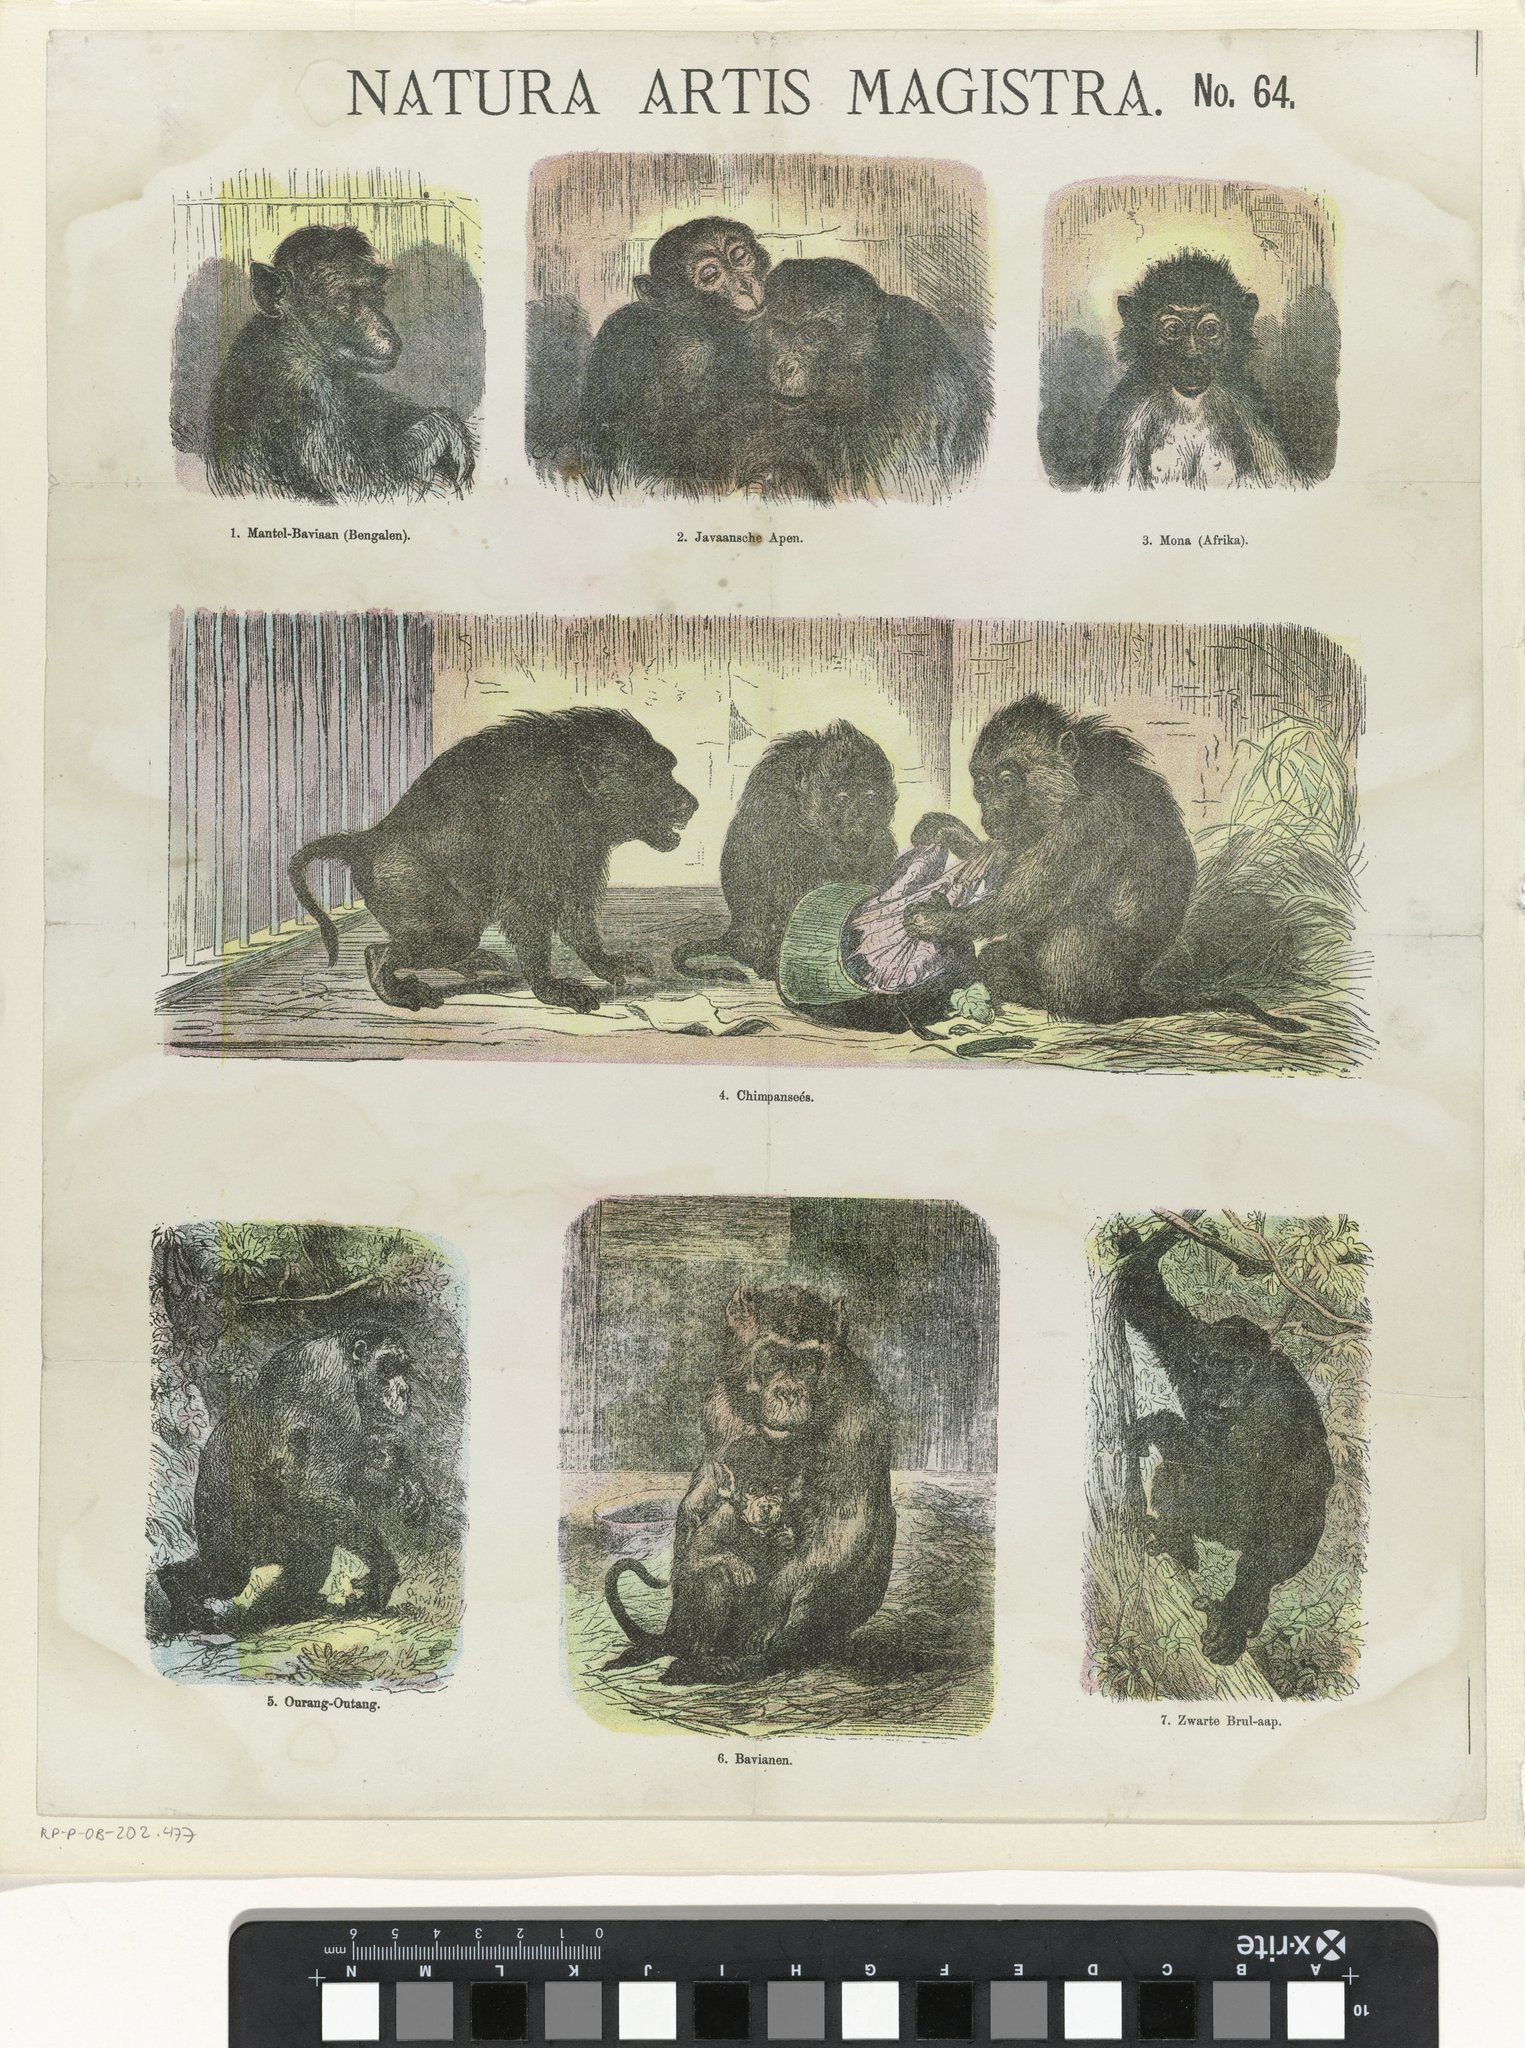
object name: popular print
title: Natura artis magistra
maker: Anonymous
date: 1878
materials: paper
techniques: lithograph, letterpress printing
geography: amsterdam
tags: monkeys, apes: baboon, monkeys, apes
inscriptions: collector's mark: Lugt 2760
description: Blad met 7 voorstellingen van apen, waaronder chimpansees, orang-oetans en bavianen. Onder elke afbeelding een onderschrift. Genummerd rechtsboven: No. 64.